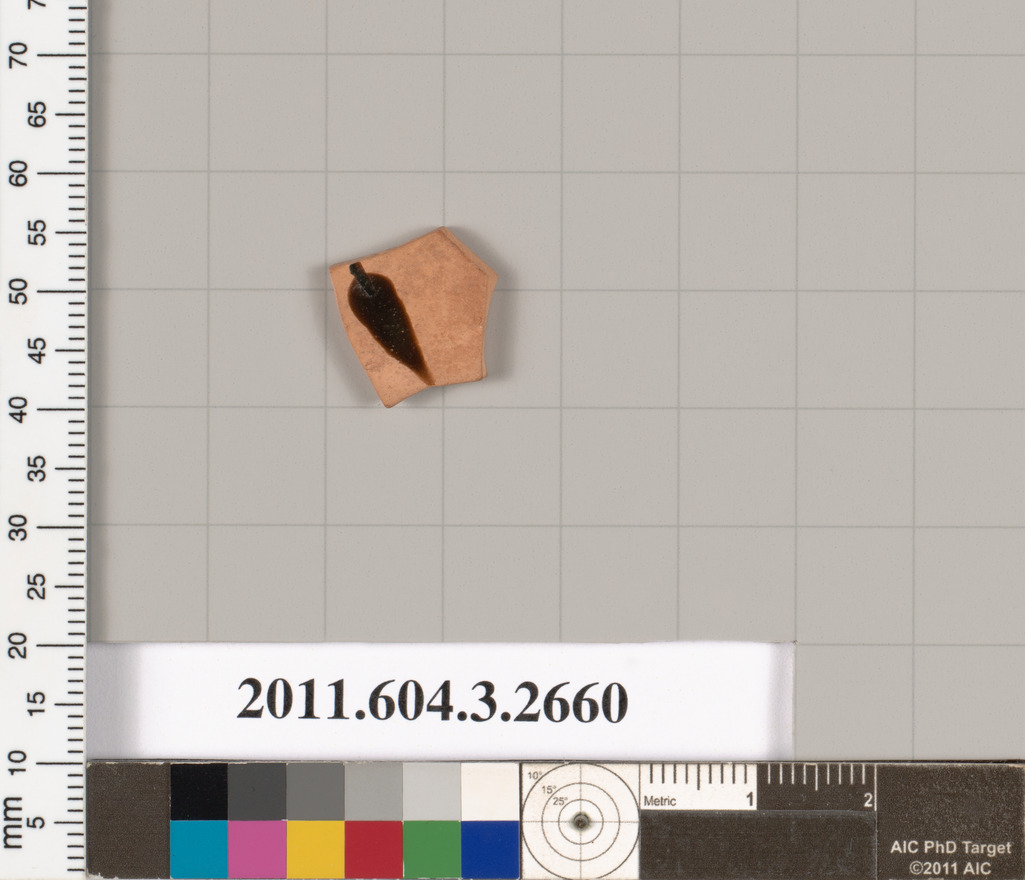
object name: oinochoe or olpe fragment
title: Terracotta fragment of an oinochoe (jug) or olpe (jug)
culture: greek, attic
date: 530-520 BCE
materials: terracotta